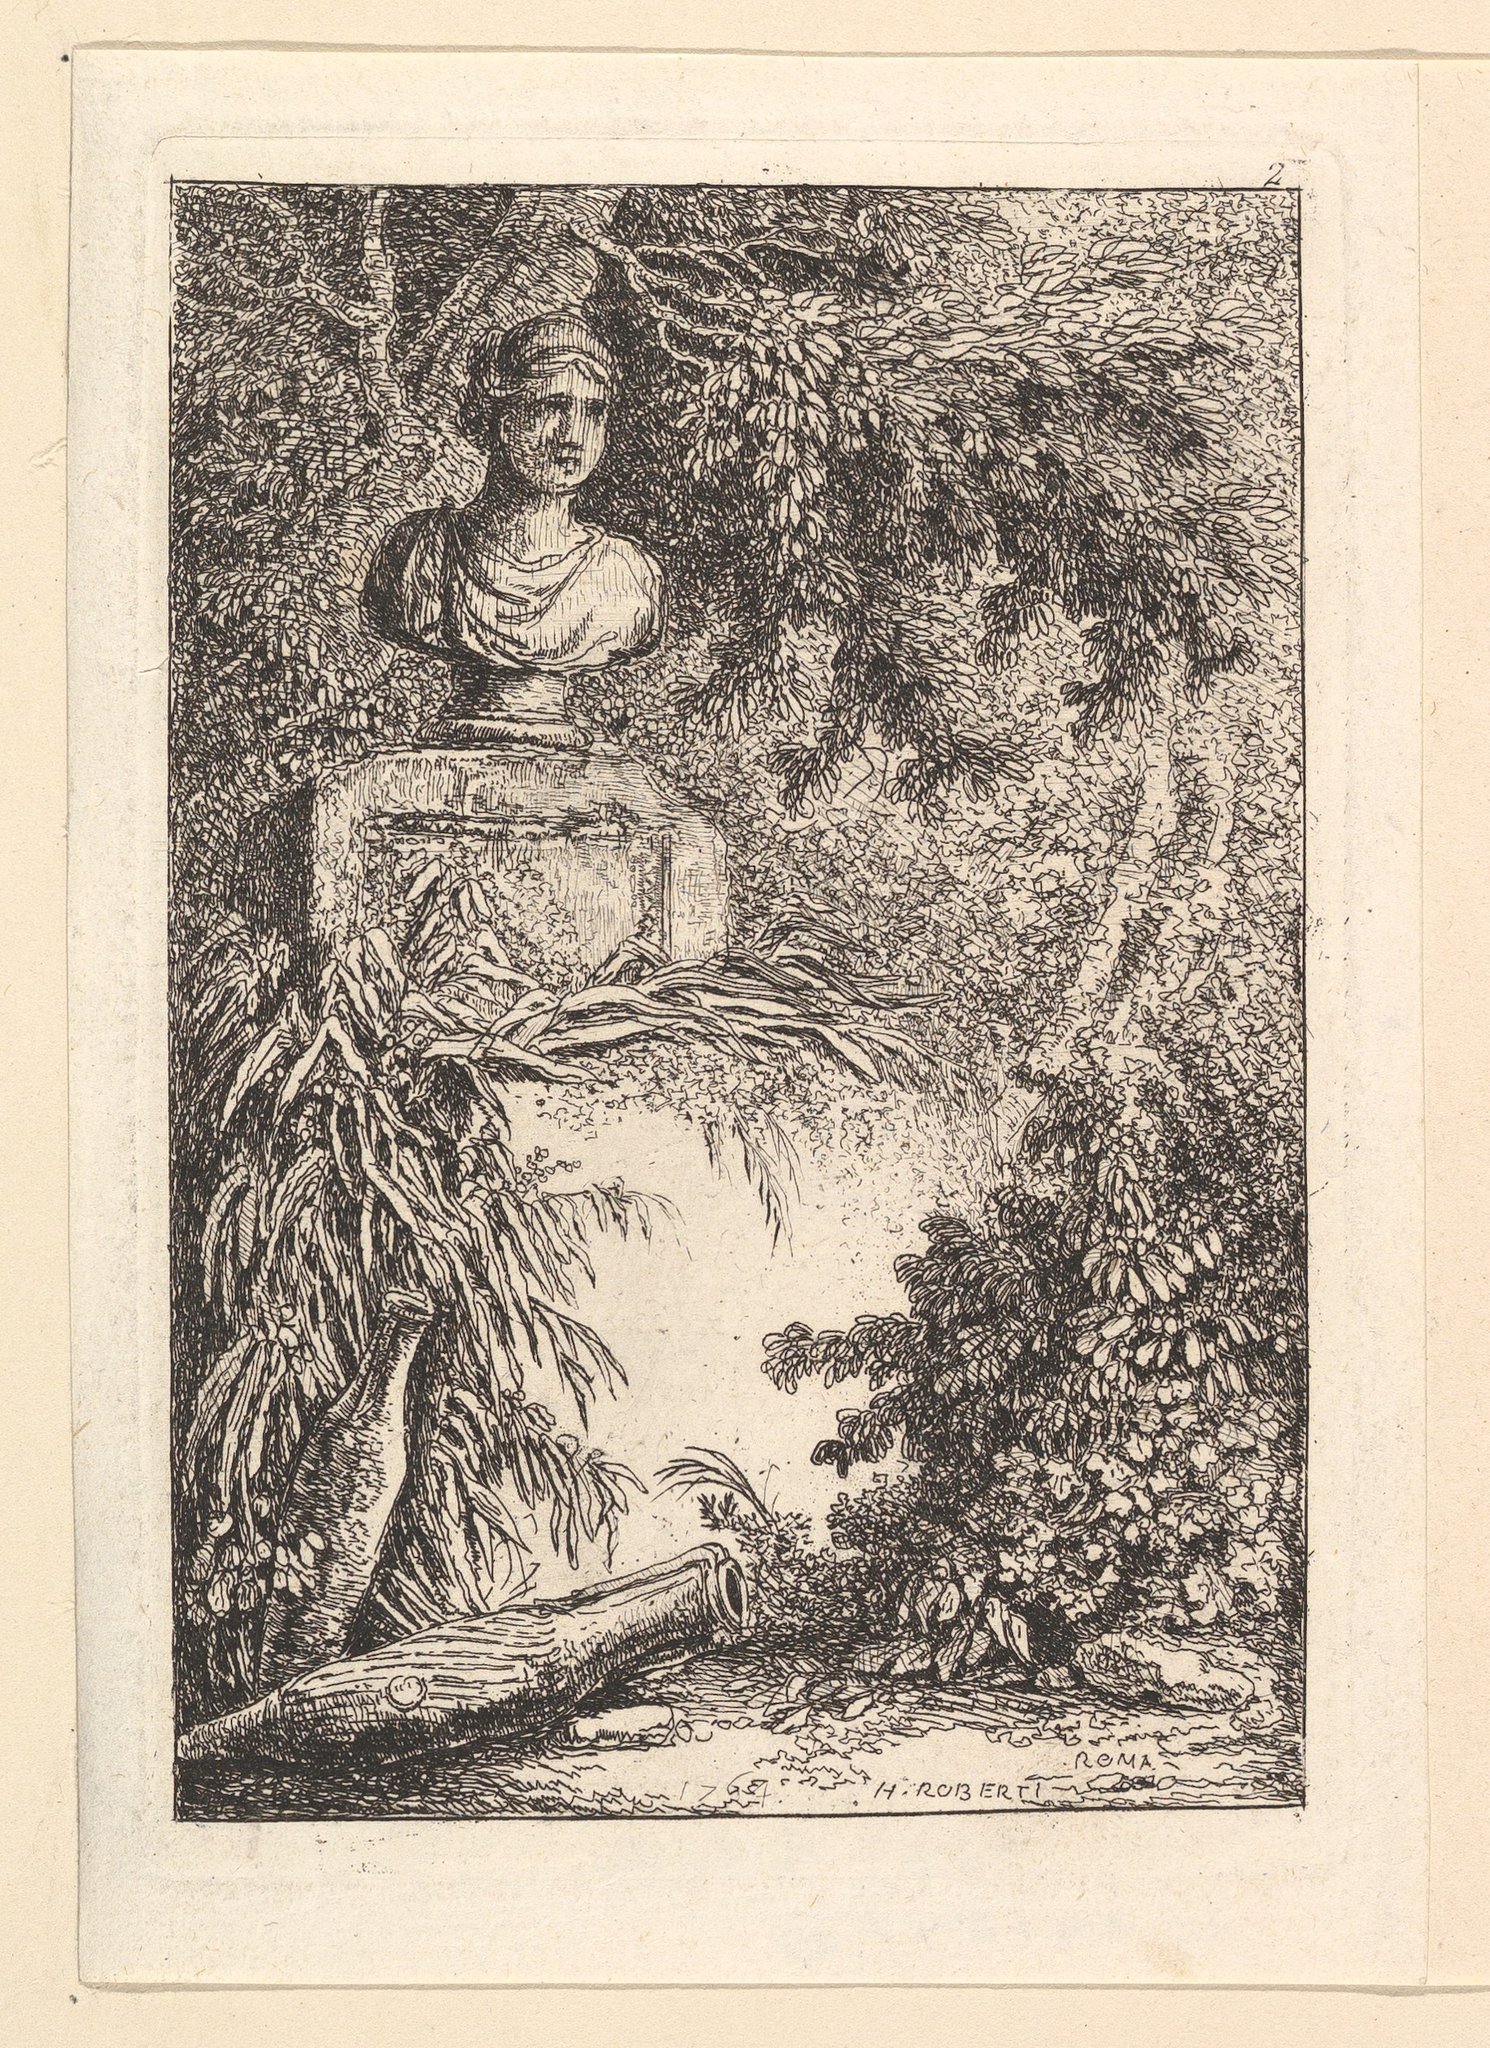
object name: print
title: Le Buste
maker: hubert robert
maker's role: artist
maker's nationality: french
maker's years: 1733-1808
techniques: etching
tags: sculpture,trees